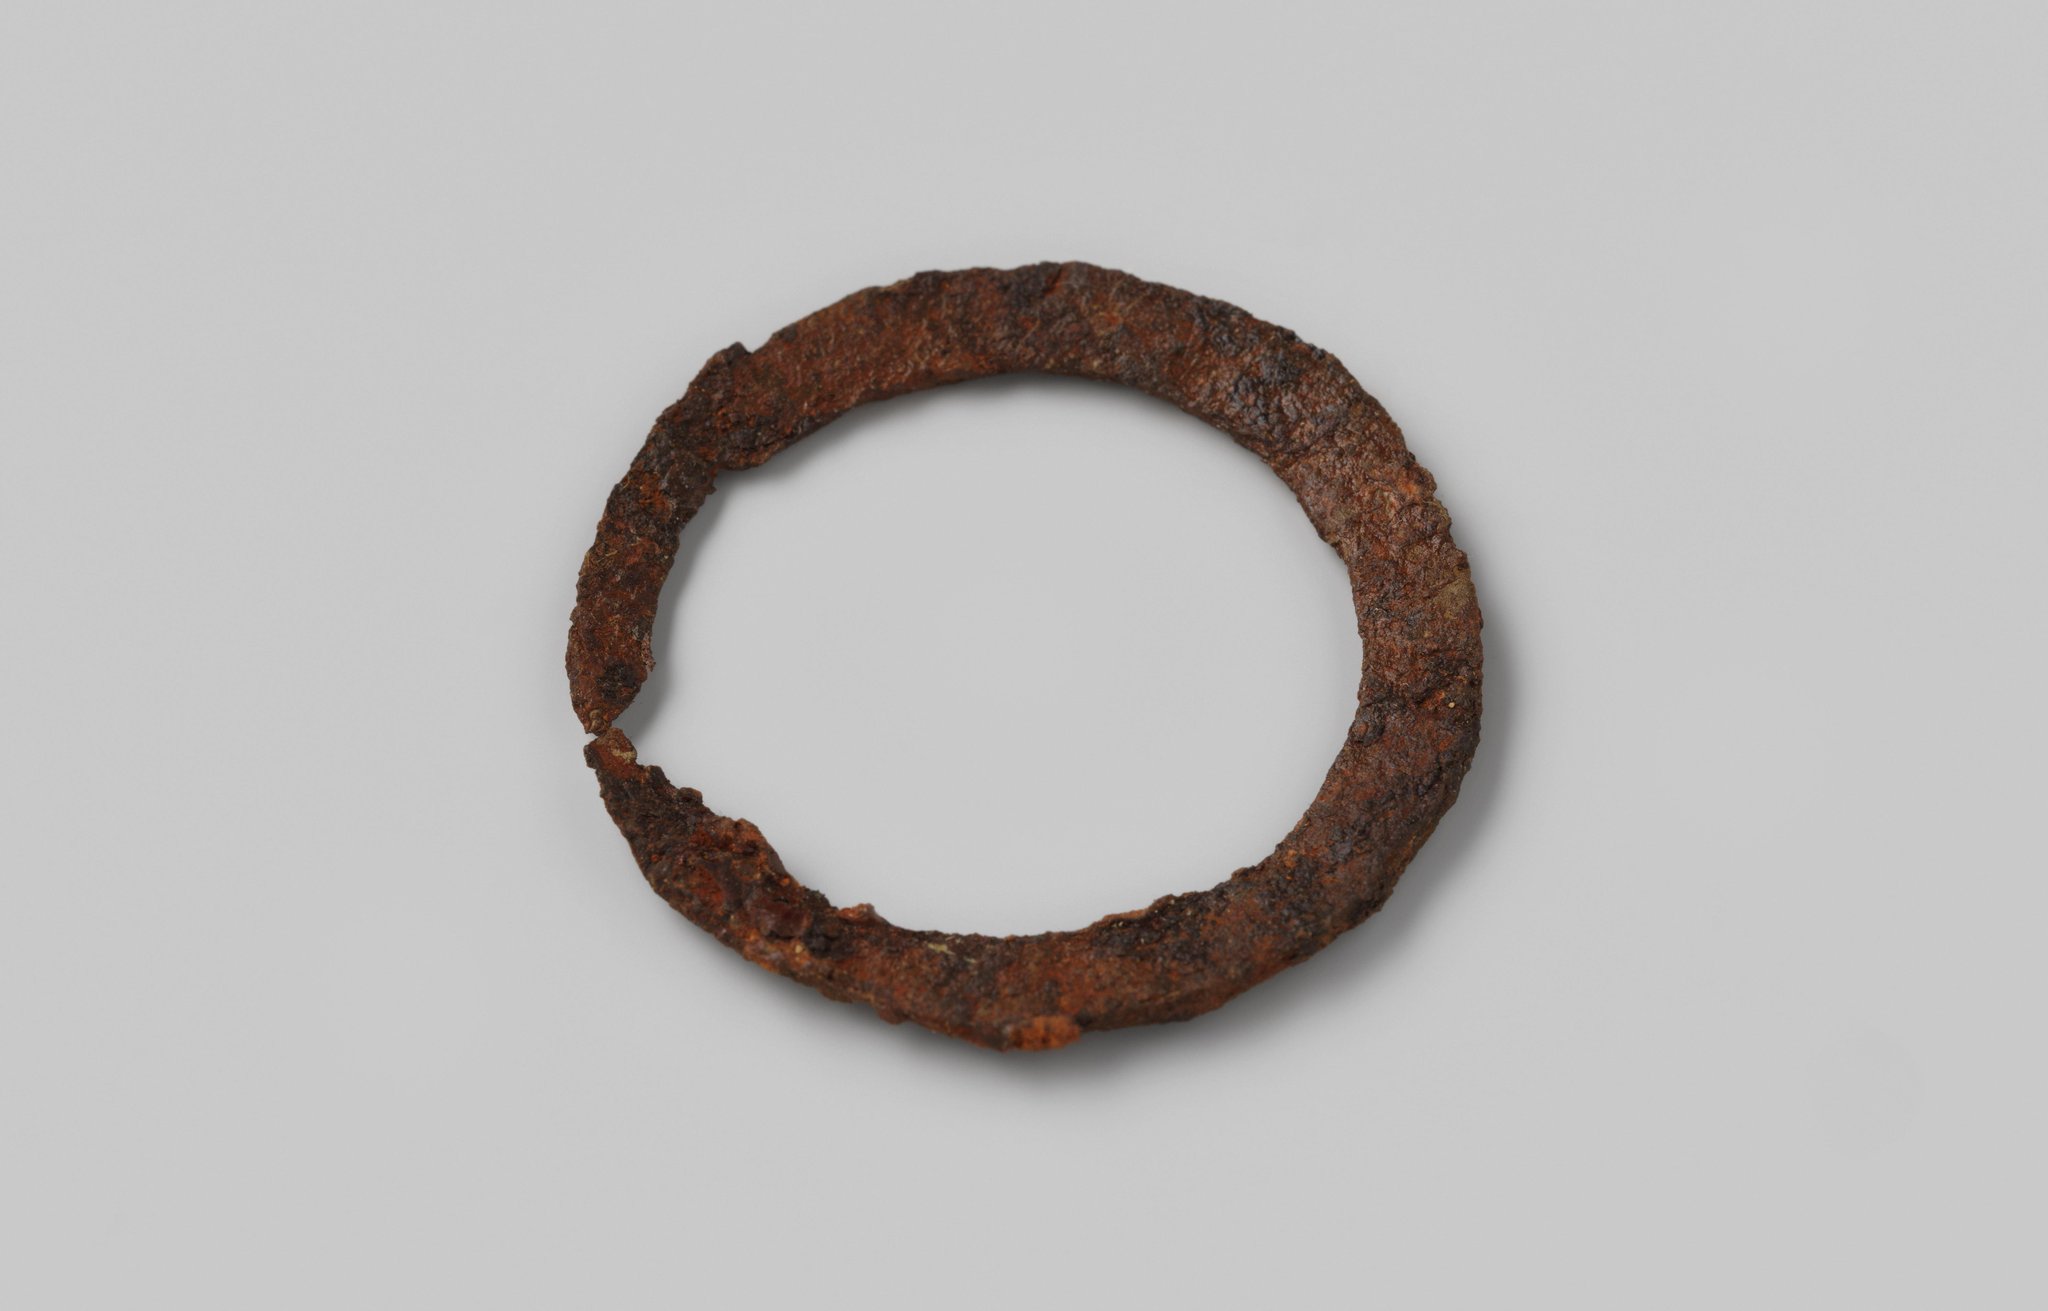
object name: fragment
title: Ringvormig fragment uit het wrak van de Oost-Indiëvaarder Hollandia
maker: Anonymous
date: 1700-1743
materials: iron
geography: netherlands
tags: verenigde oostindische compagnie, hollandia (schip), annet